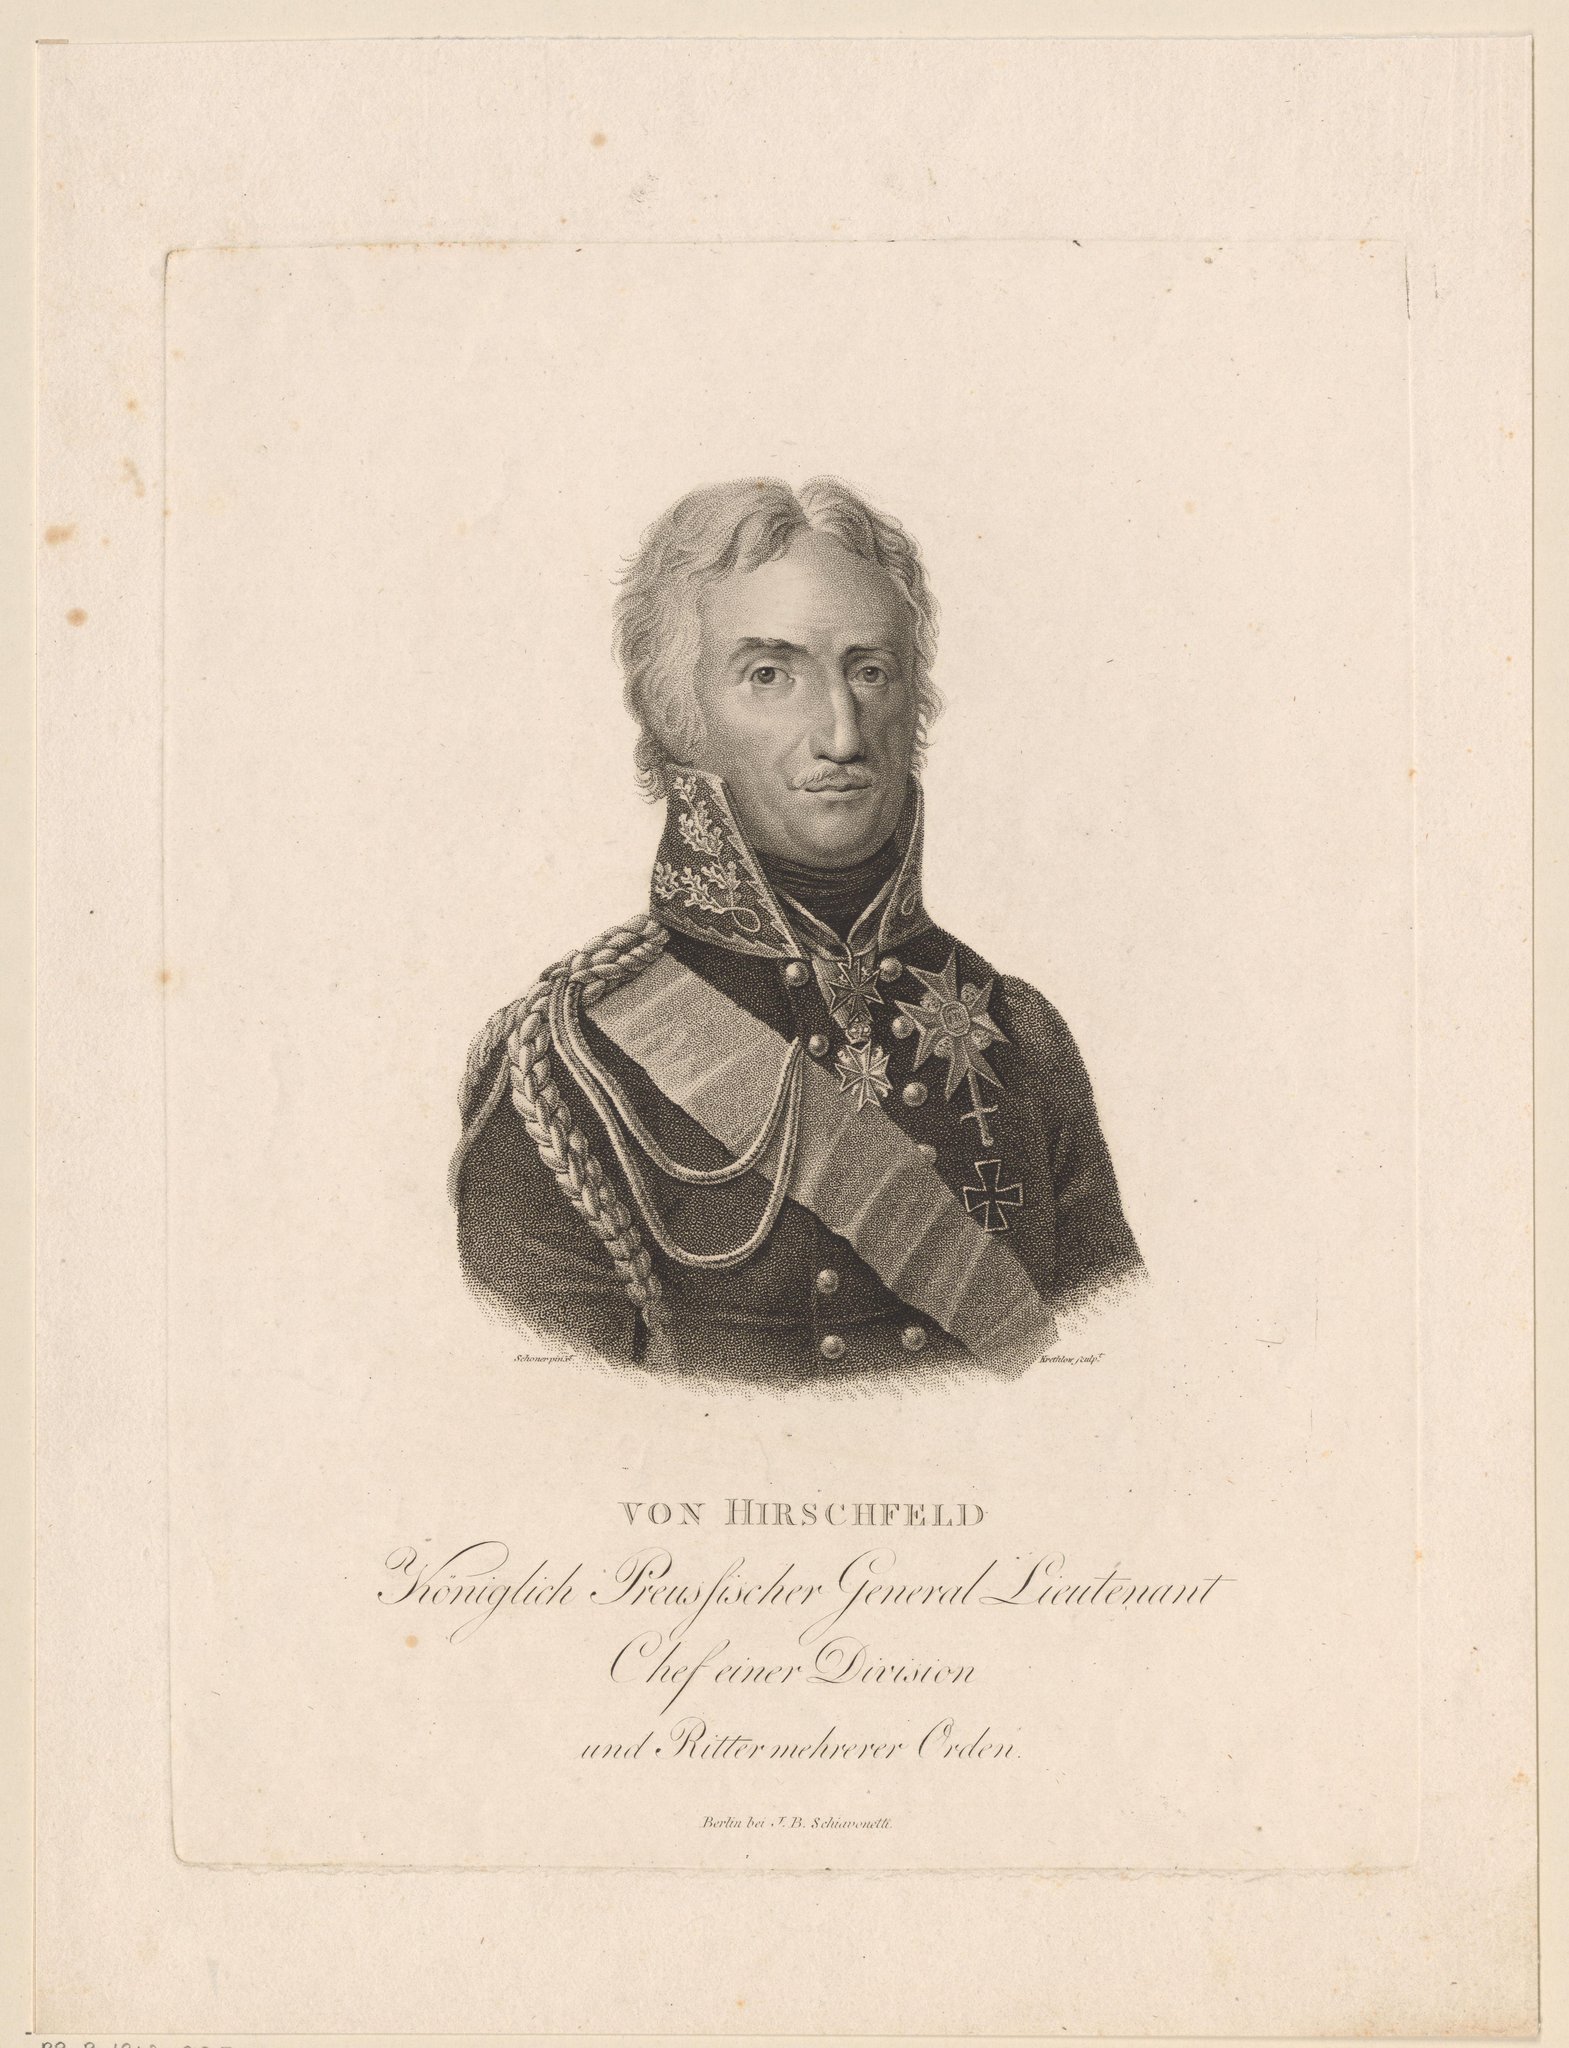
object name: print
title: Portret van Karl Friedrich von Hirschfeld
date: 1806-1820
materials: paper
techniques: engraving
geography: berlin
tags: commander-in-chief, general, marshal, historical persons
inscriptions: collector's mark: Lugt 2233